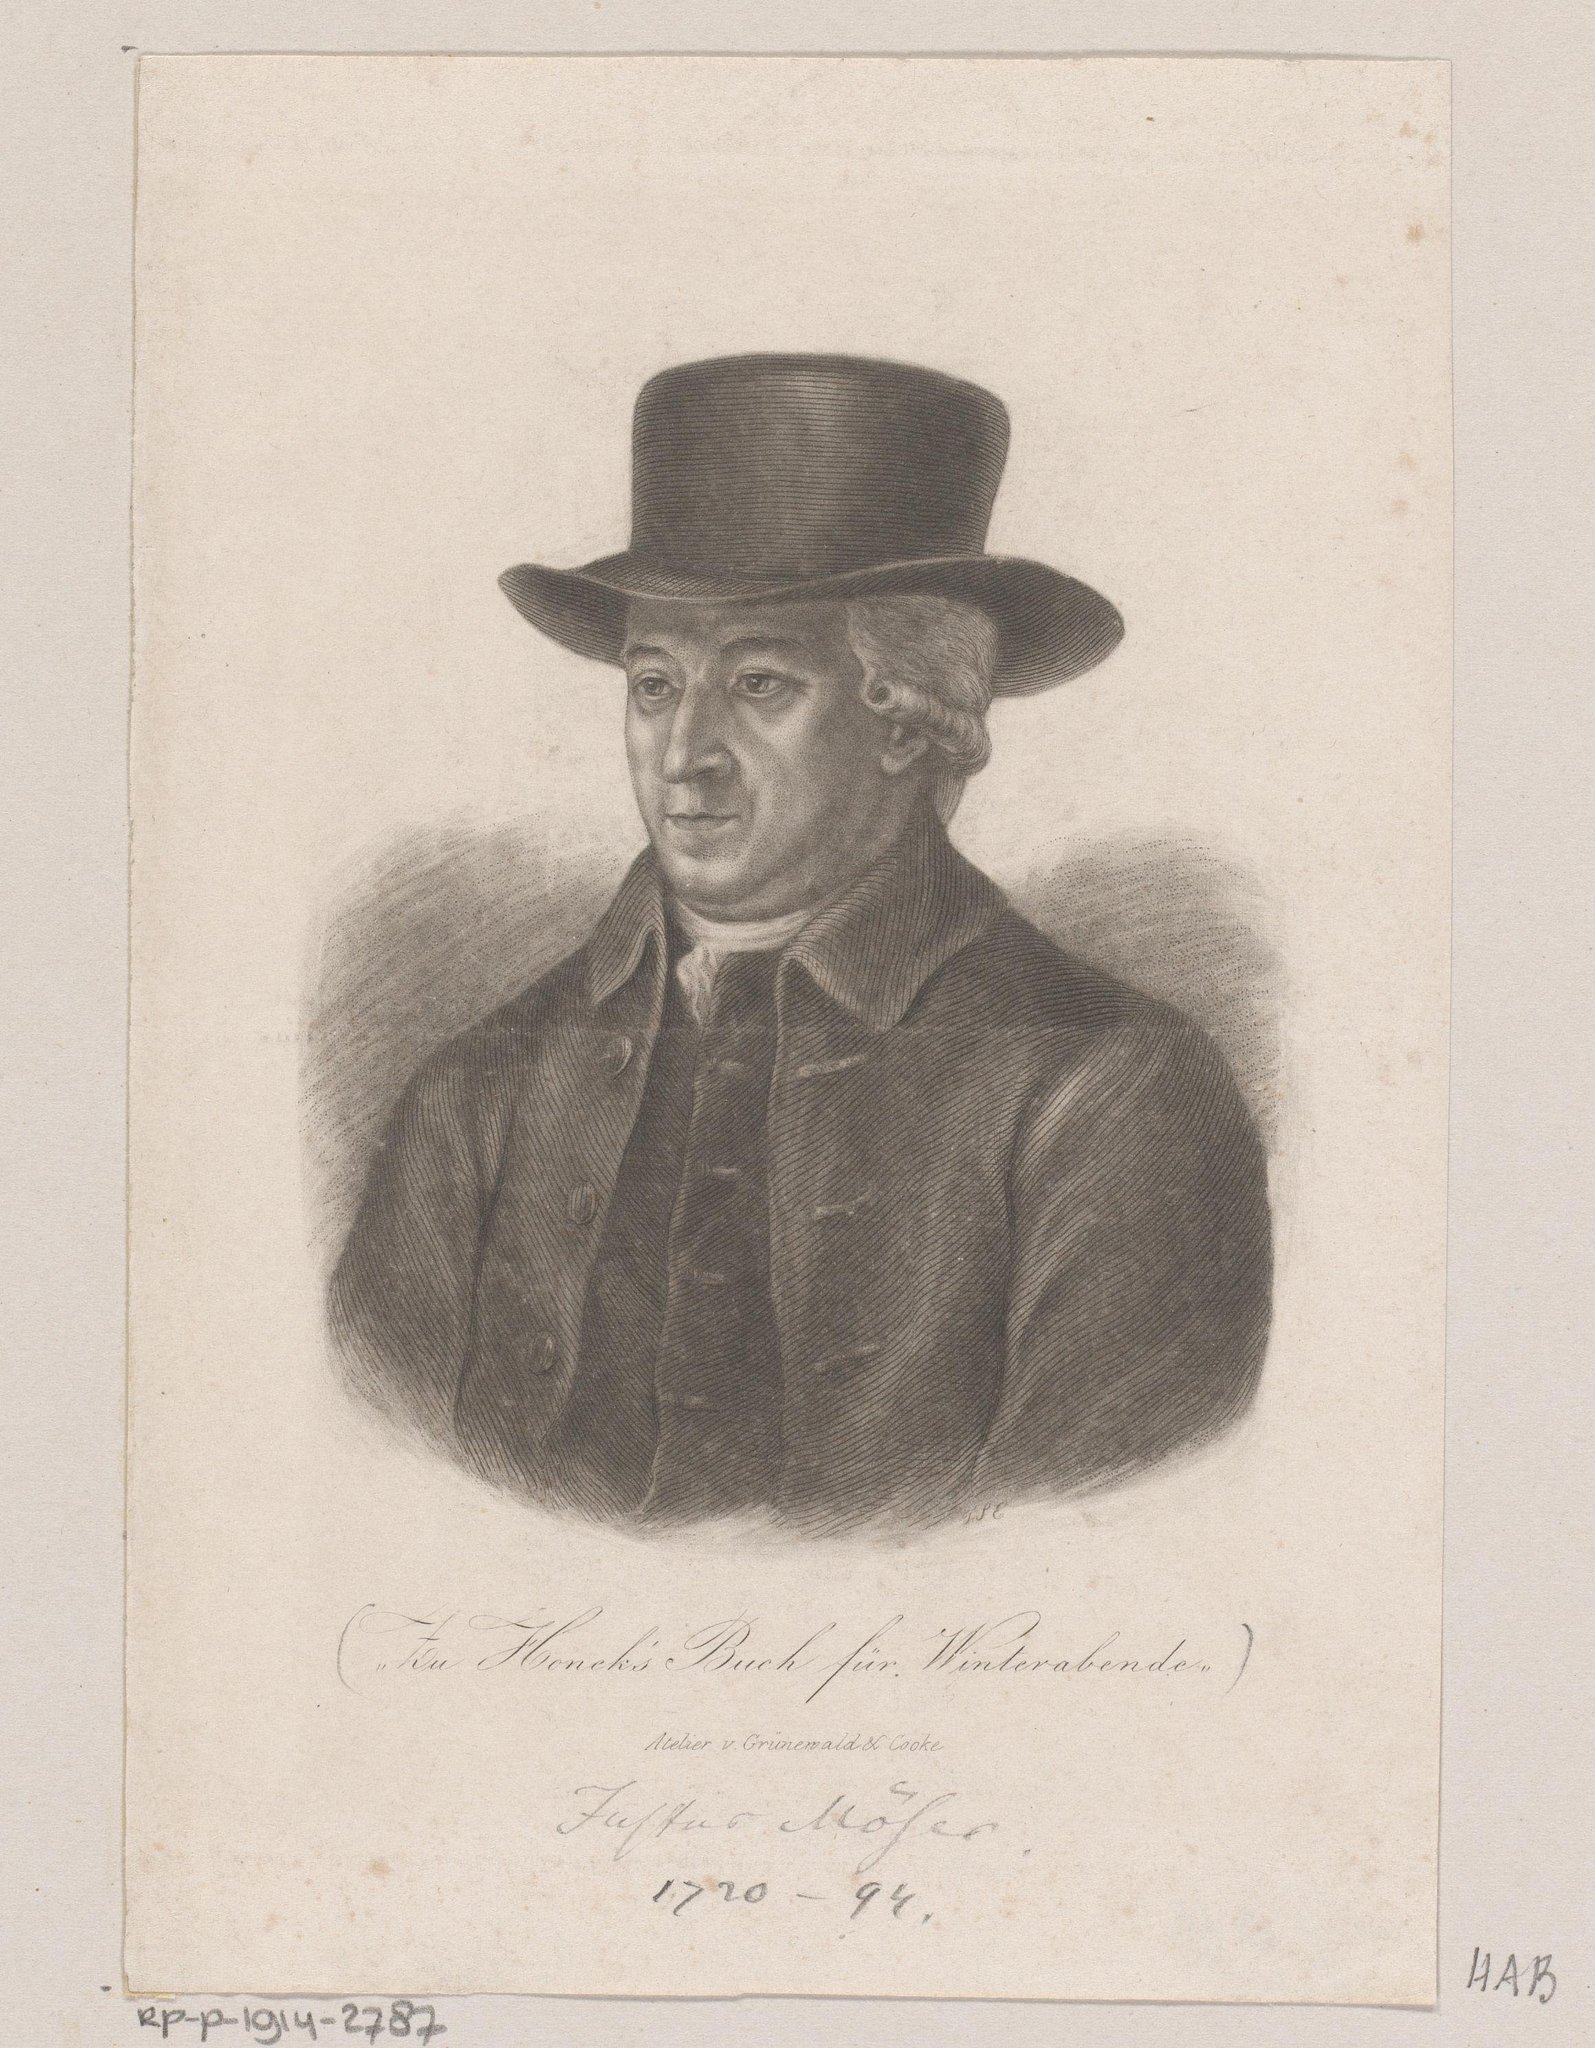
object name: print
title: Portret van Justus Möser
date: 1811-1848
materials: paper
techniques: intaglio, roulette, engraving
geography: darmstadt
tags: historical persons, lawyer, attorney at law, portrait of a writer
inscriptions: collector's mark: Lugt 2228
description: Met eenregelig onderschrift in het Duits.